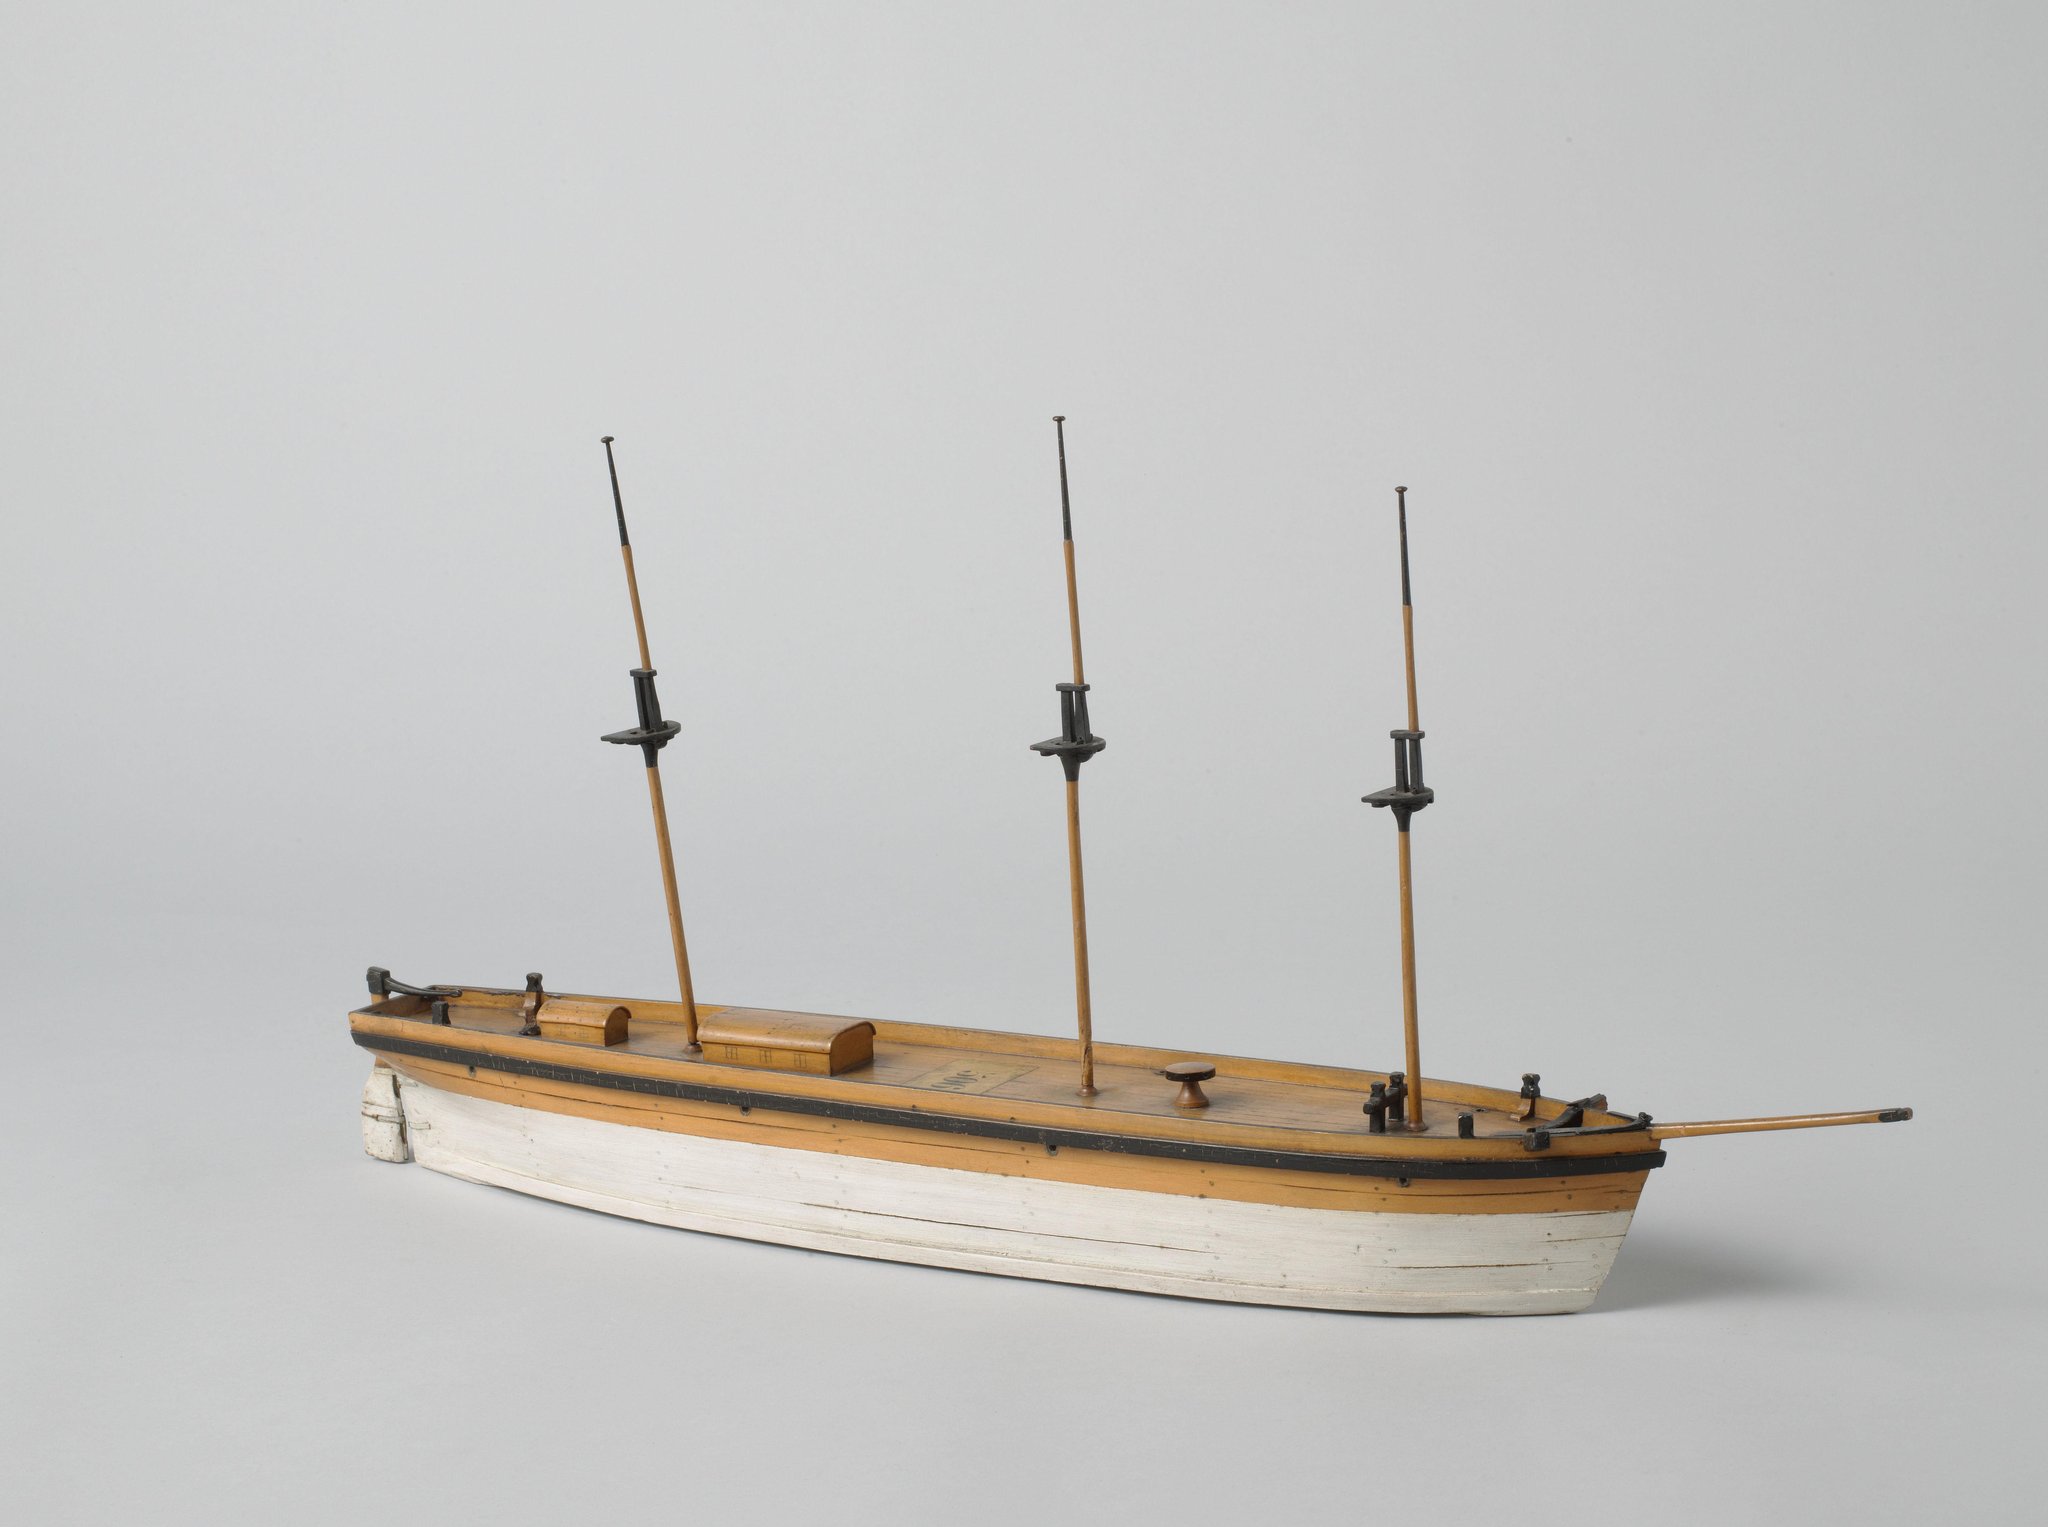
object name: ship model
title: Model of a Timber Ship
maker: Anonymous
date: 1824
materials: brass, wood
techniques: polychromy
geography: netherlands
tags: québec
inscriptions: inscription, on the stern: ‘COLUMBUS’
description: Het houtschip Columbus werd in 1824 door Charles Wood op Anse du Fort, Isle of Orleans, vier mijl van Quebec, gebouwd. Houtschepen waren schepen opgebouwd uit hout voor de scheepsbouw, zowel rondhout als romphout, en werden bij aankomst uiteengenomen om het hout voor de handel te gebruiken; zij werden daarenboven nog eens met hout geladen. De voornaamste overweging voor hun bouw was het drukken van de vrachtkosten van scheepshout, maar op deze wijze konden ook de invoerrechten op timmerhout omzeild worden. De reis van de Columbus naar Londen was zo een succes, dat de eigenaars tegen het advies van Wood in afzagen van het oorspronkelijke plan om het schip af te breken, en het terugstuurden voor een tweede lading hout. Deze reis werd fataal.